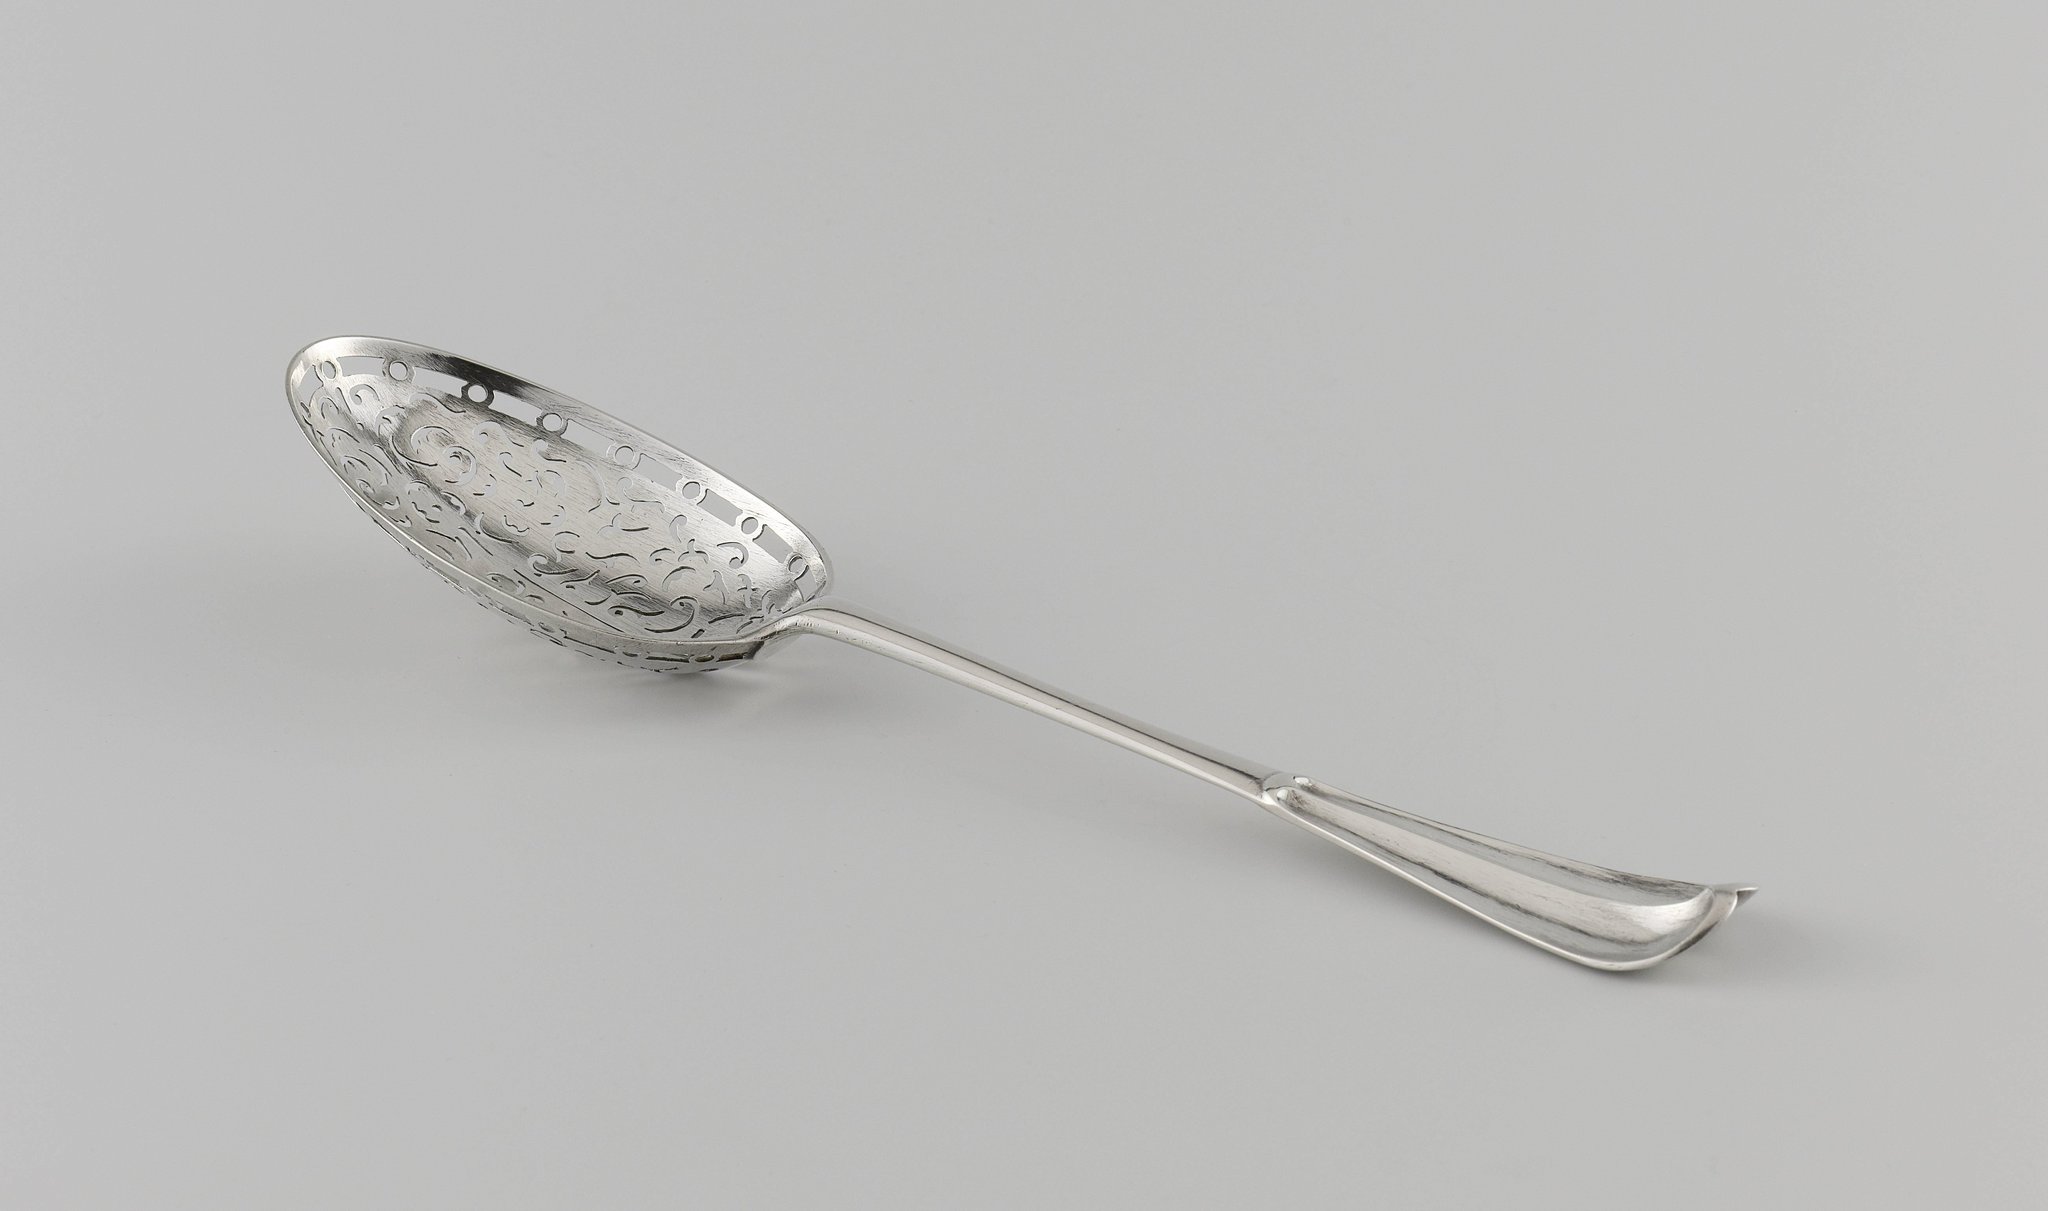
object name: spoon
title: Vruchtenlepel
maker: Anonymous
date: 1731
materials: silver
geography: haarlem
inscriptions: mark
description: Een grote zilveren vruchtenlepel, met een ajour bewerkte ovale bak. De gebogen steel verbreedt zich tot een holle tweelobbige greep. Merken: Haarlem, Holland, met de jaarletter W (1731), en een bijltje. Meesterteken P.D.